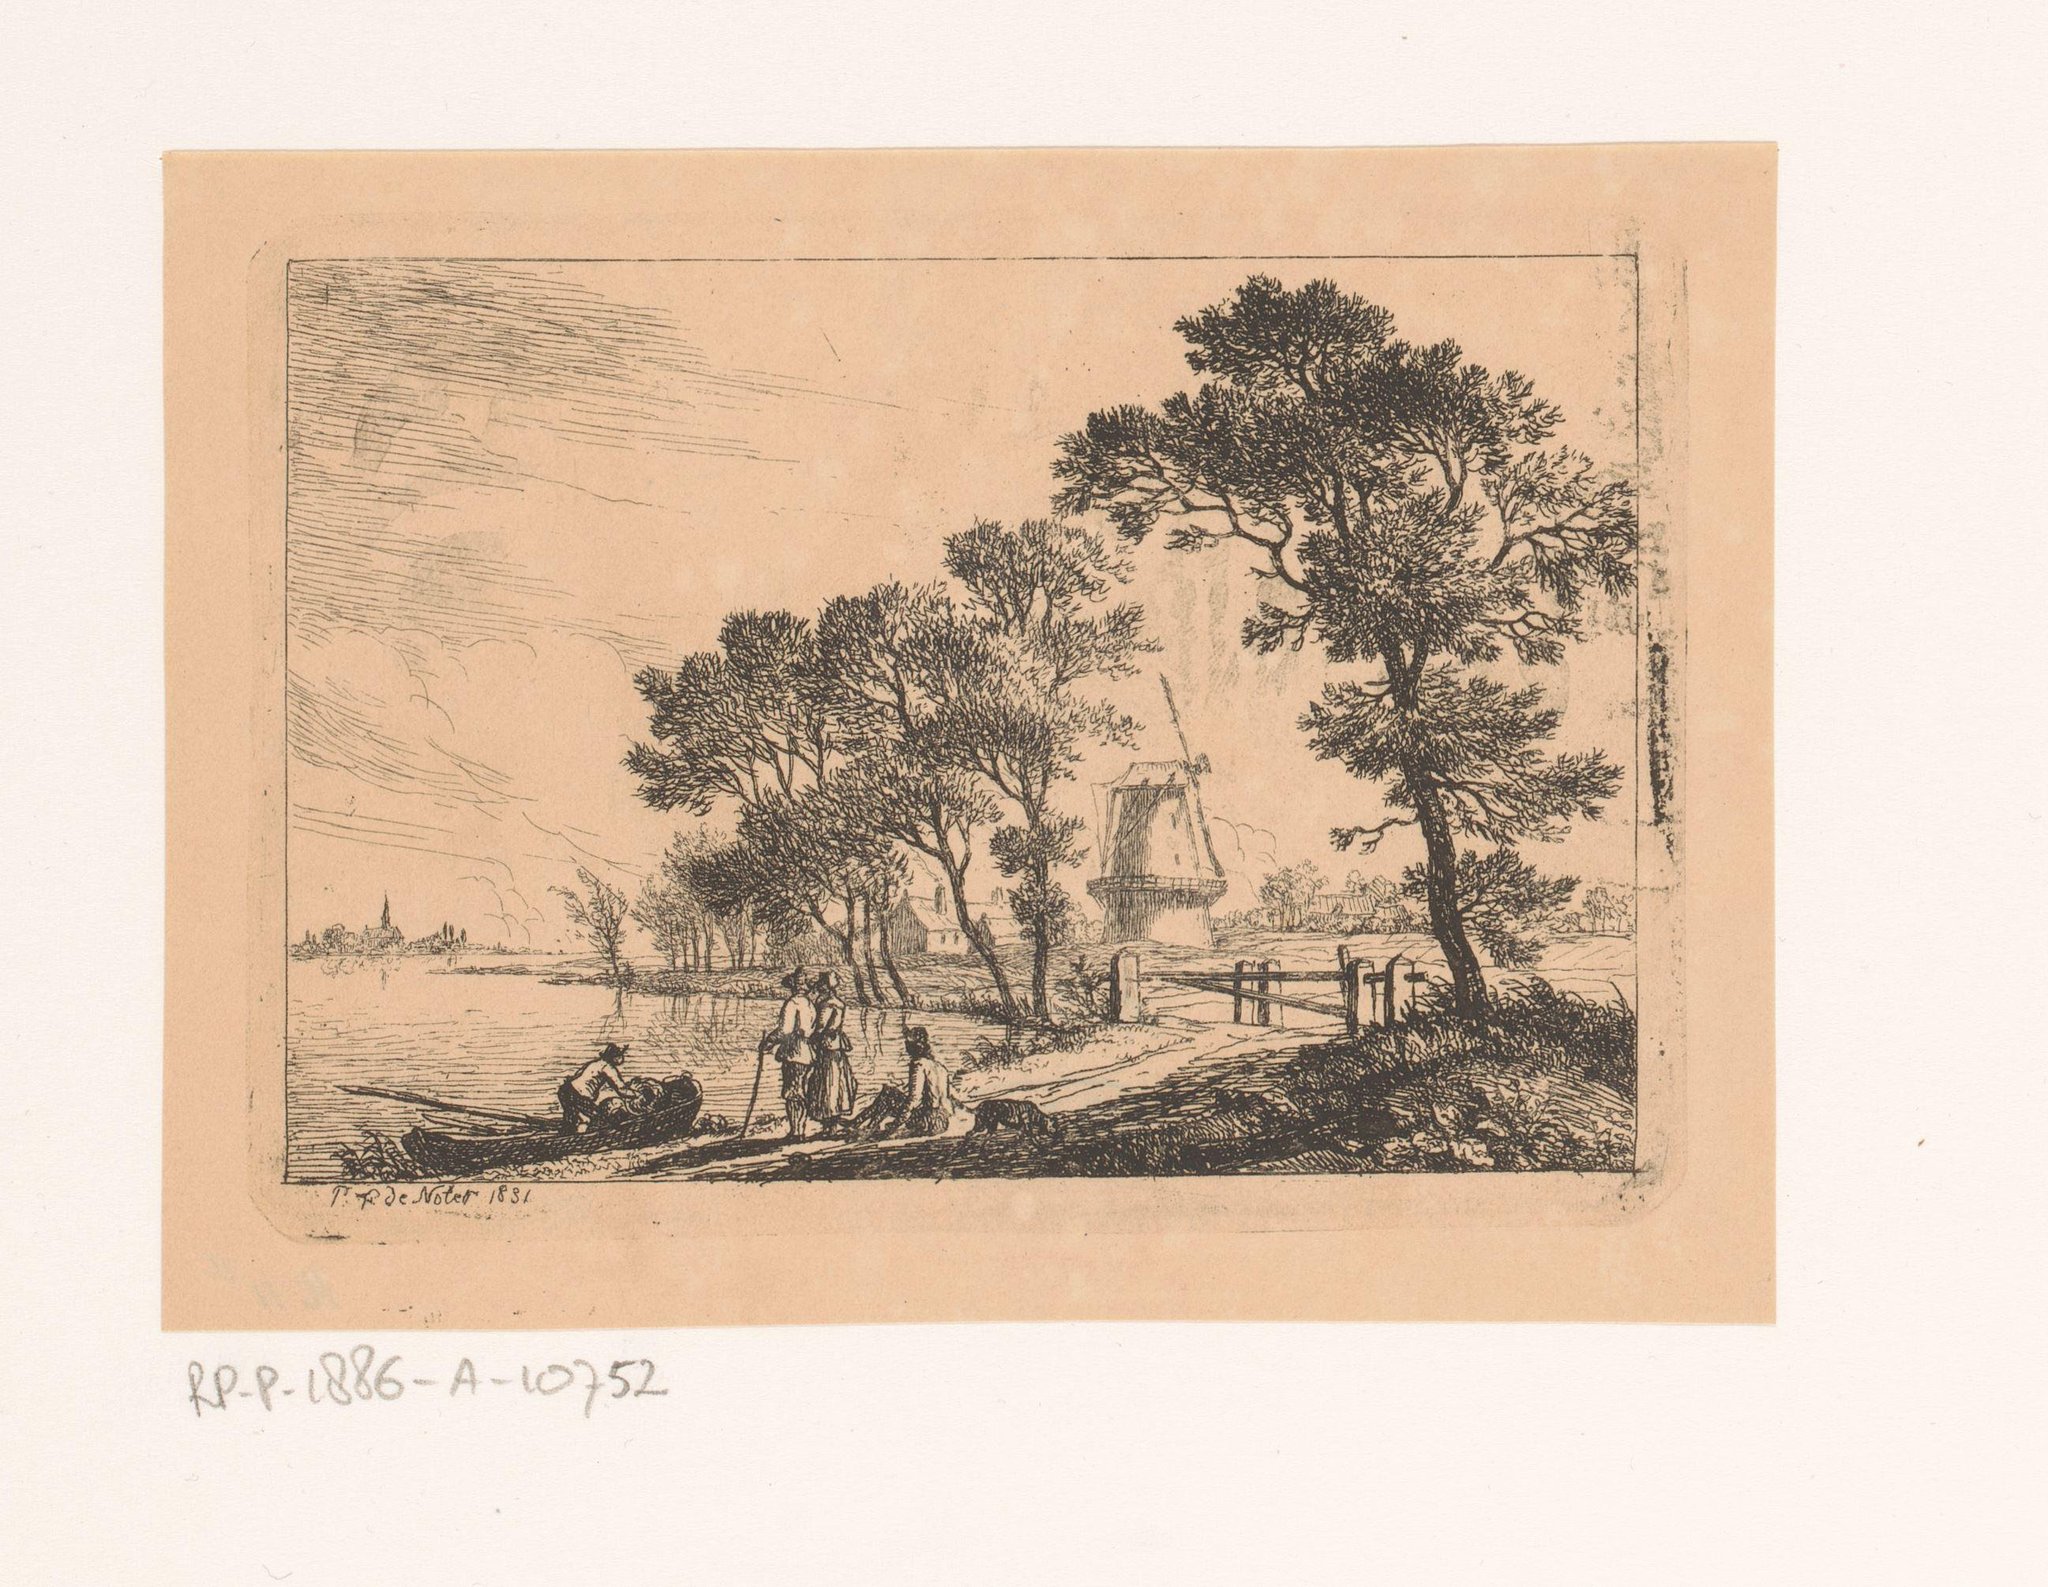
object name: print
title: Landschap met figuren langs een oever en een windmolen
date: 1831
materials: paper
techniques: etching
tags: landscapes with waters, waterscapes, seascapes (in the temperate zone), rowing-boat, canoe, etc., windmill in landscape (+ city(-scape) with figures, staffage)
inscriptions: collector's mark: Lugt 2228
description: Prent behoort mogelijk tot de prentserie: Recueil de Gravures à l'eau forte, dont plusieurs d'apres Hobbema, par P.F. de Noter. Gent: s.n., 1831.